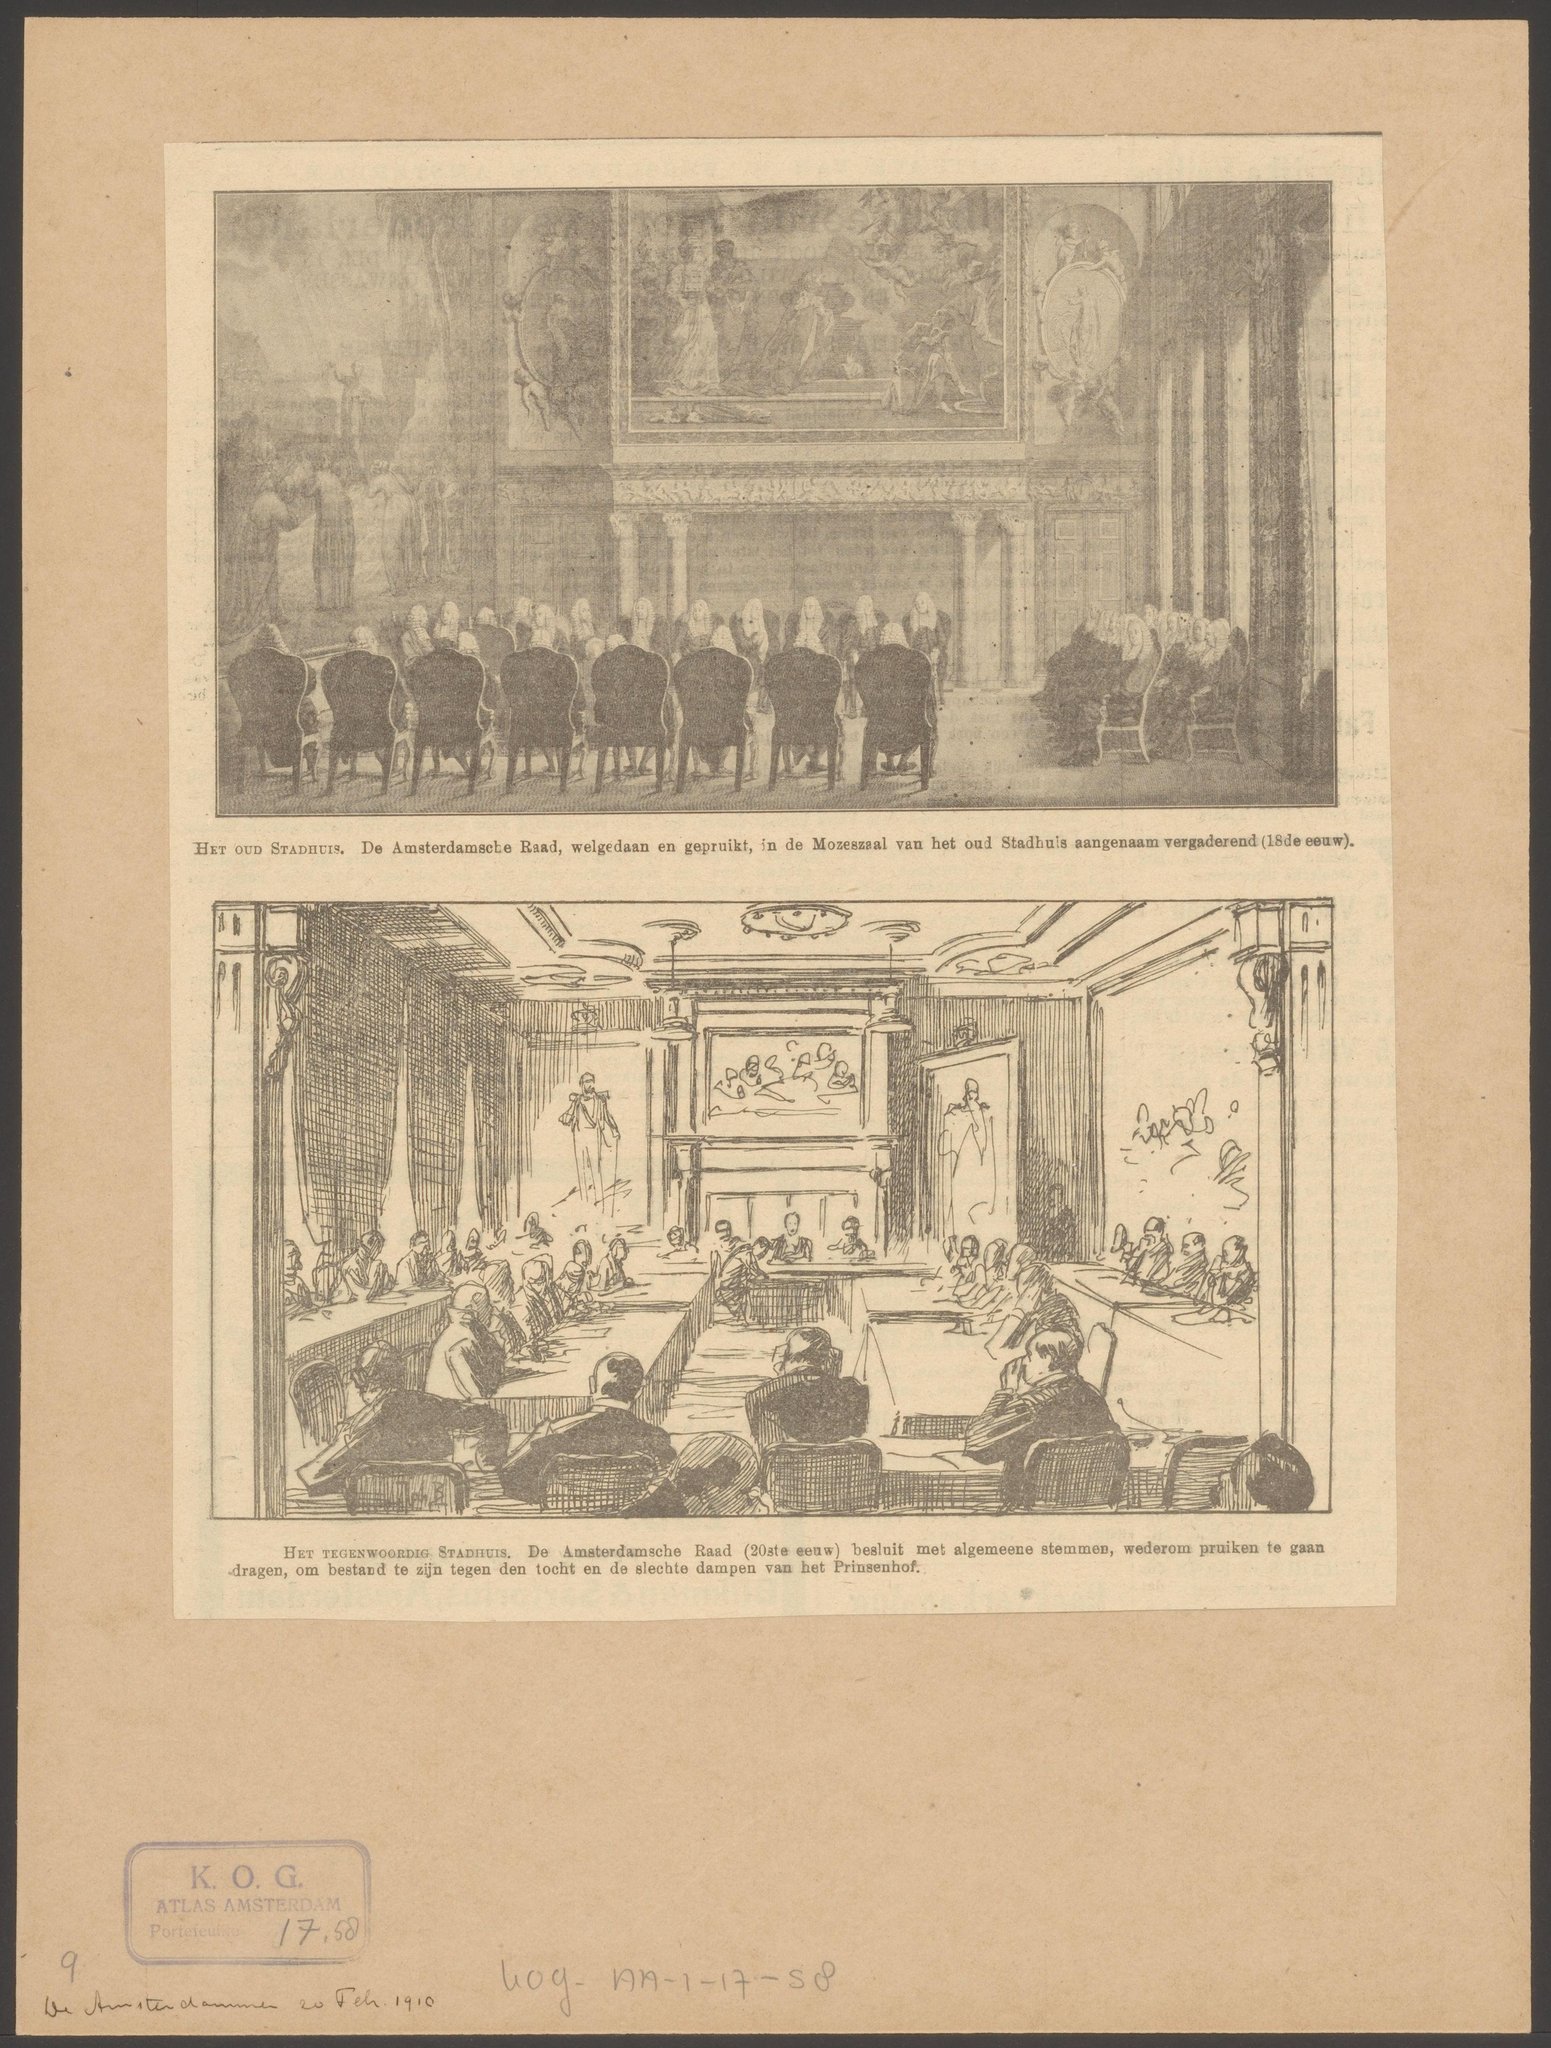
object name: photomechanical print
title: Gezicht op de Raadzalen van het oude stadhuis op de Dam en het nieuwe stadhuis op het Prinsenhof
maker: Anonymous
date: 1910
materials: paper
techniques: letterpress printing, line block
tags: townhall, debate, discussion (~ meeting)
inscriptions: collector's mark: ‘17,58’ Lugt 1641b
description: Onderwerpsrubriek binnen de Atlas Amsterdam: Nieuwe Stadhuis, van binnen: Vaartuigen en Gebouwen ten dienste der Stedelijke Regeering en Administratie; Stadhuis (Prinsenhof).